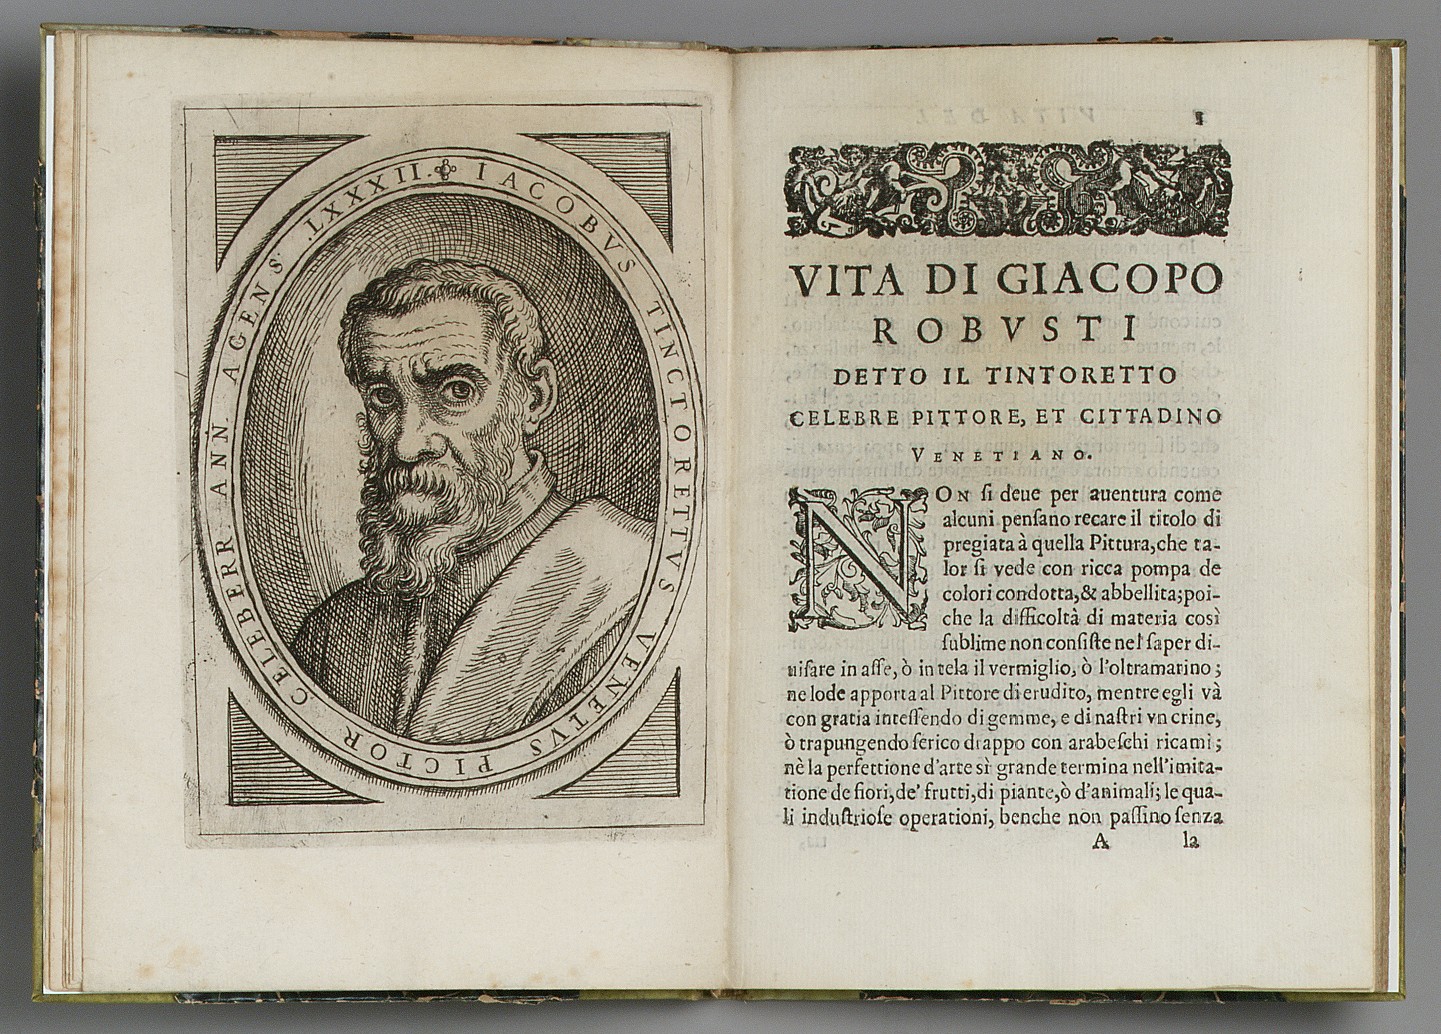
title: Vita del Tintoretto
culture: italian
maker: carlo ridolfi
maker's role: author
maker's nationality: italian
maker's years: 1594-1658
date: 1642